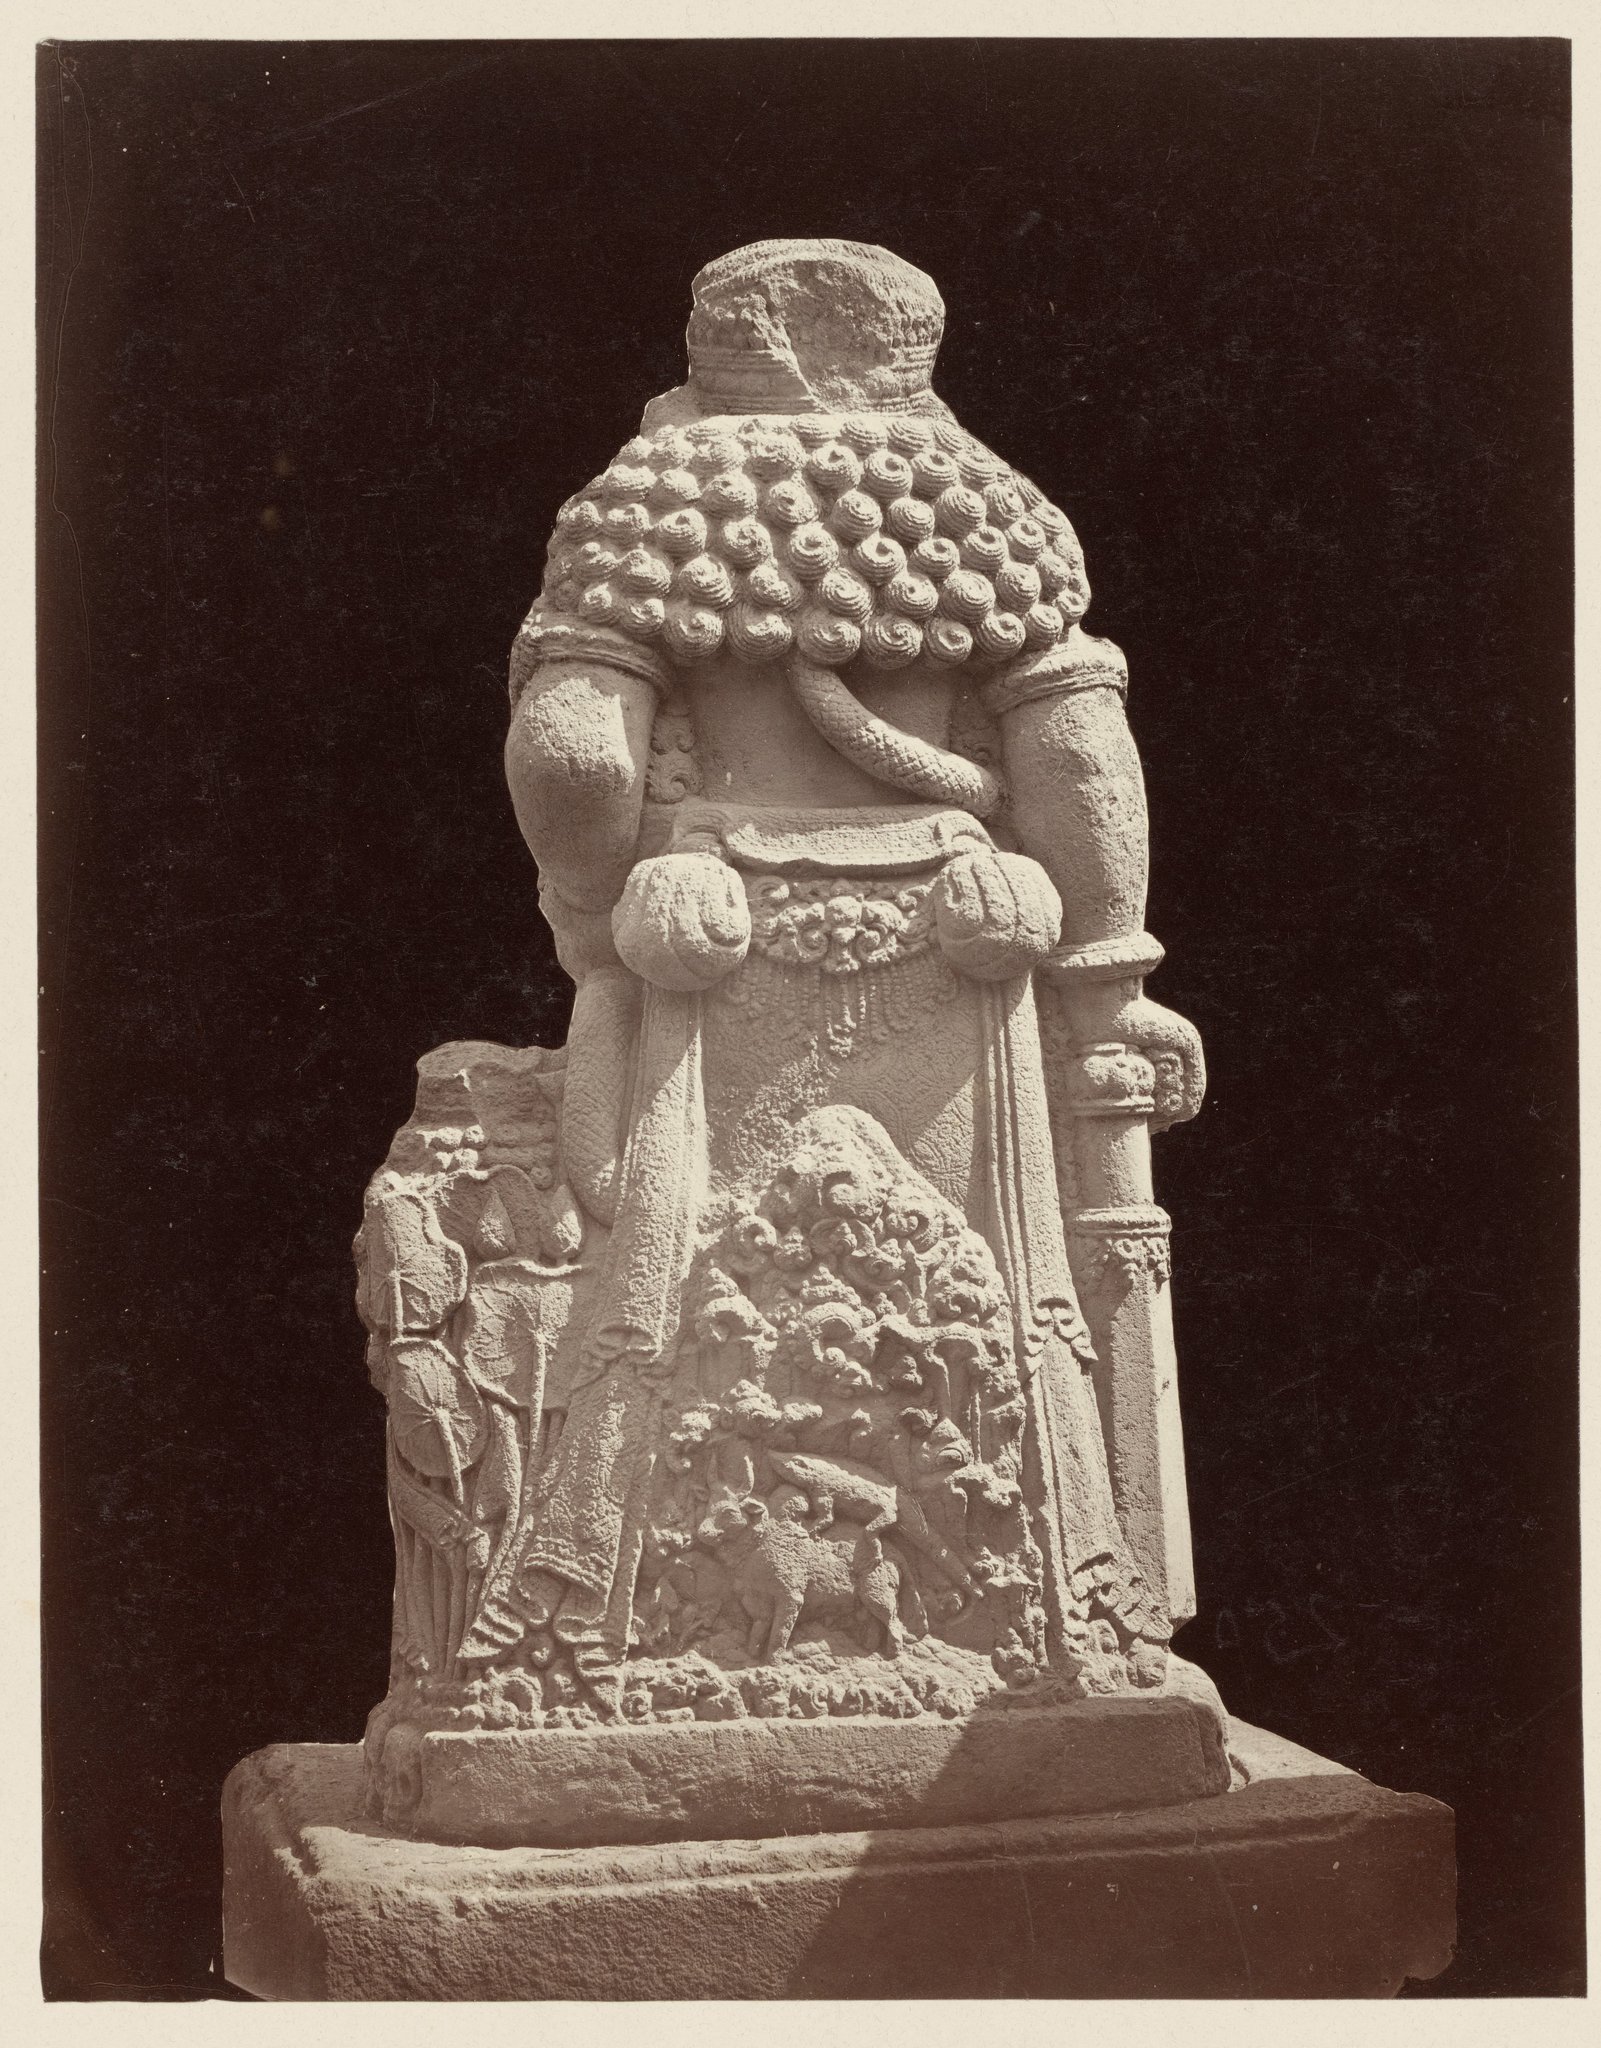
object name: photograph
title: Candi Panataran (Temple complex), Main Temple; rear of the same dvarapala, decorated with a scene from the Tantri fable 'Crocodile and Bull', Panataran, Blitar district, East Java province 1323-1347, Indonesia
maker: isidore kinsbergen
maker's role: fotograaf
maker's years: 1821-1905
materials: cardboard, paper, photographic support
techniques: albumen print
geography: java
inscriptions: number: ‘44’, title: ‘Siva als tempelwachter (?) staande voor den tempel (achterzijde) te panataran (Residentie Kediri) Cat. no. 250’